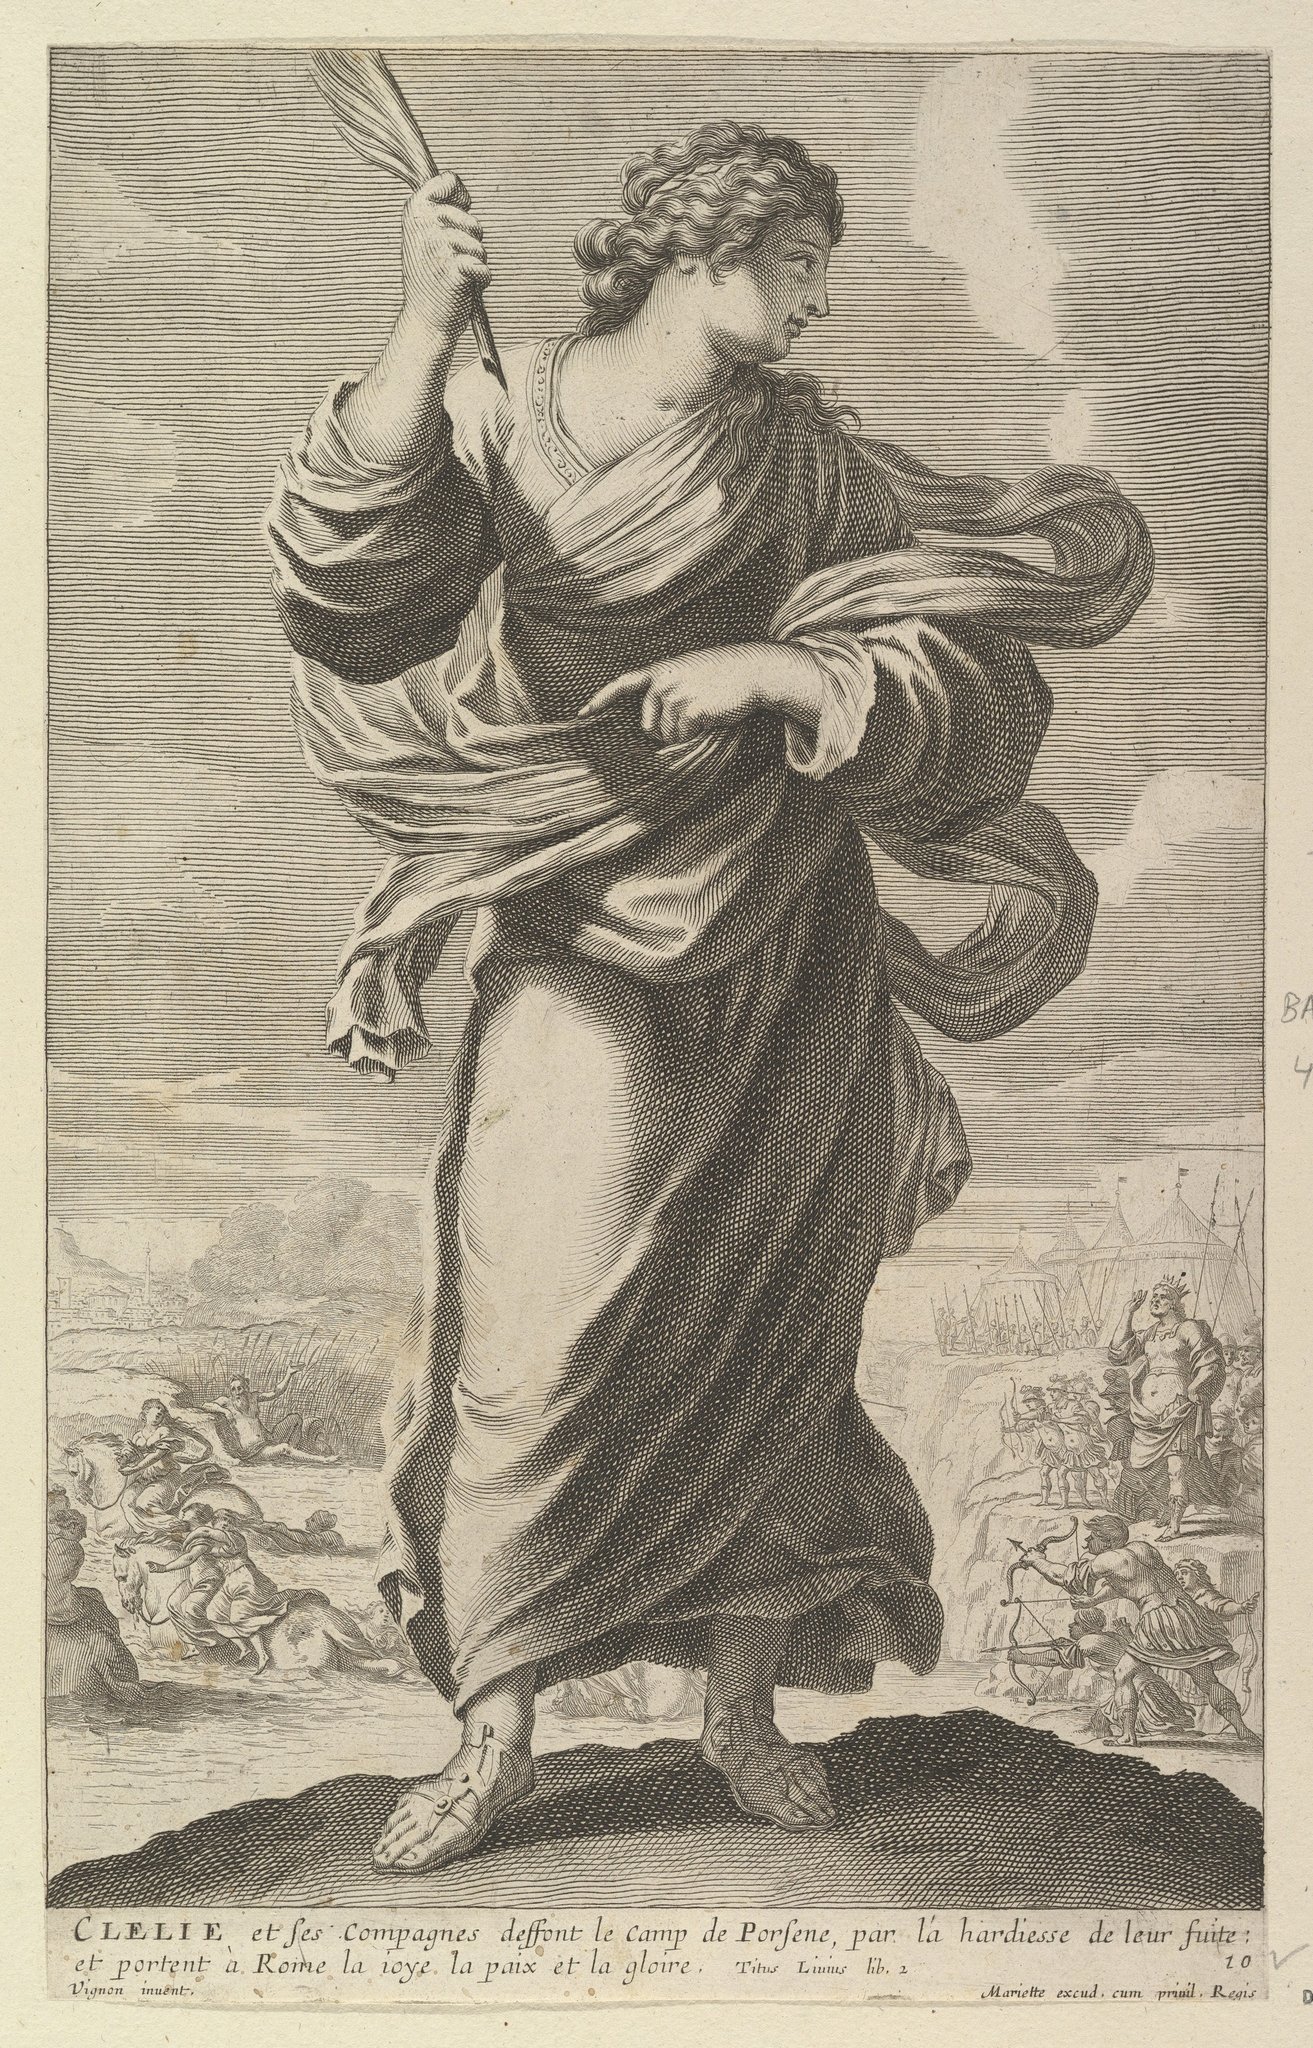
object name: print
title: Clélie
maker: gilles rousselet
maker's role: artist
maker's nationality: french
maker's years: 1614-1686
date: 1647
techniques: engraving, etching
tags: women